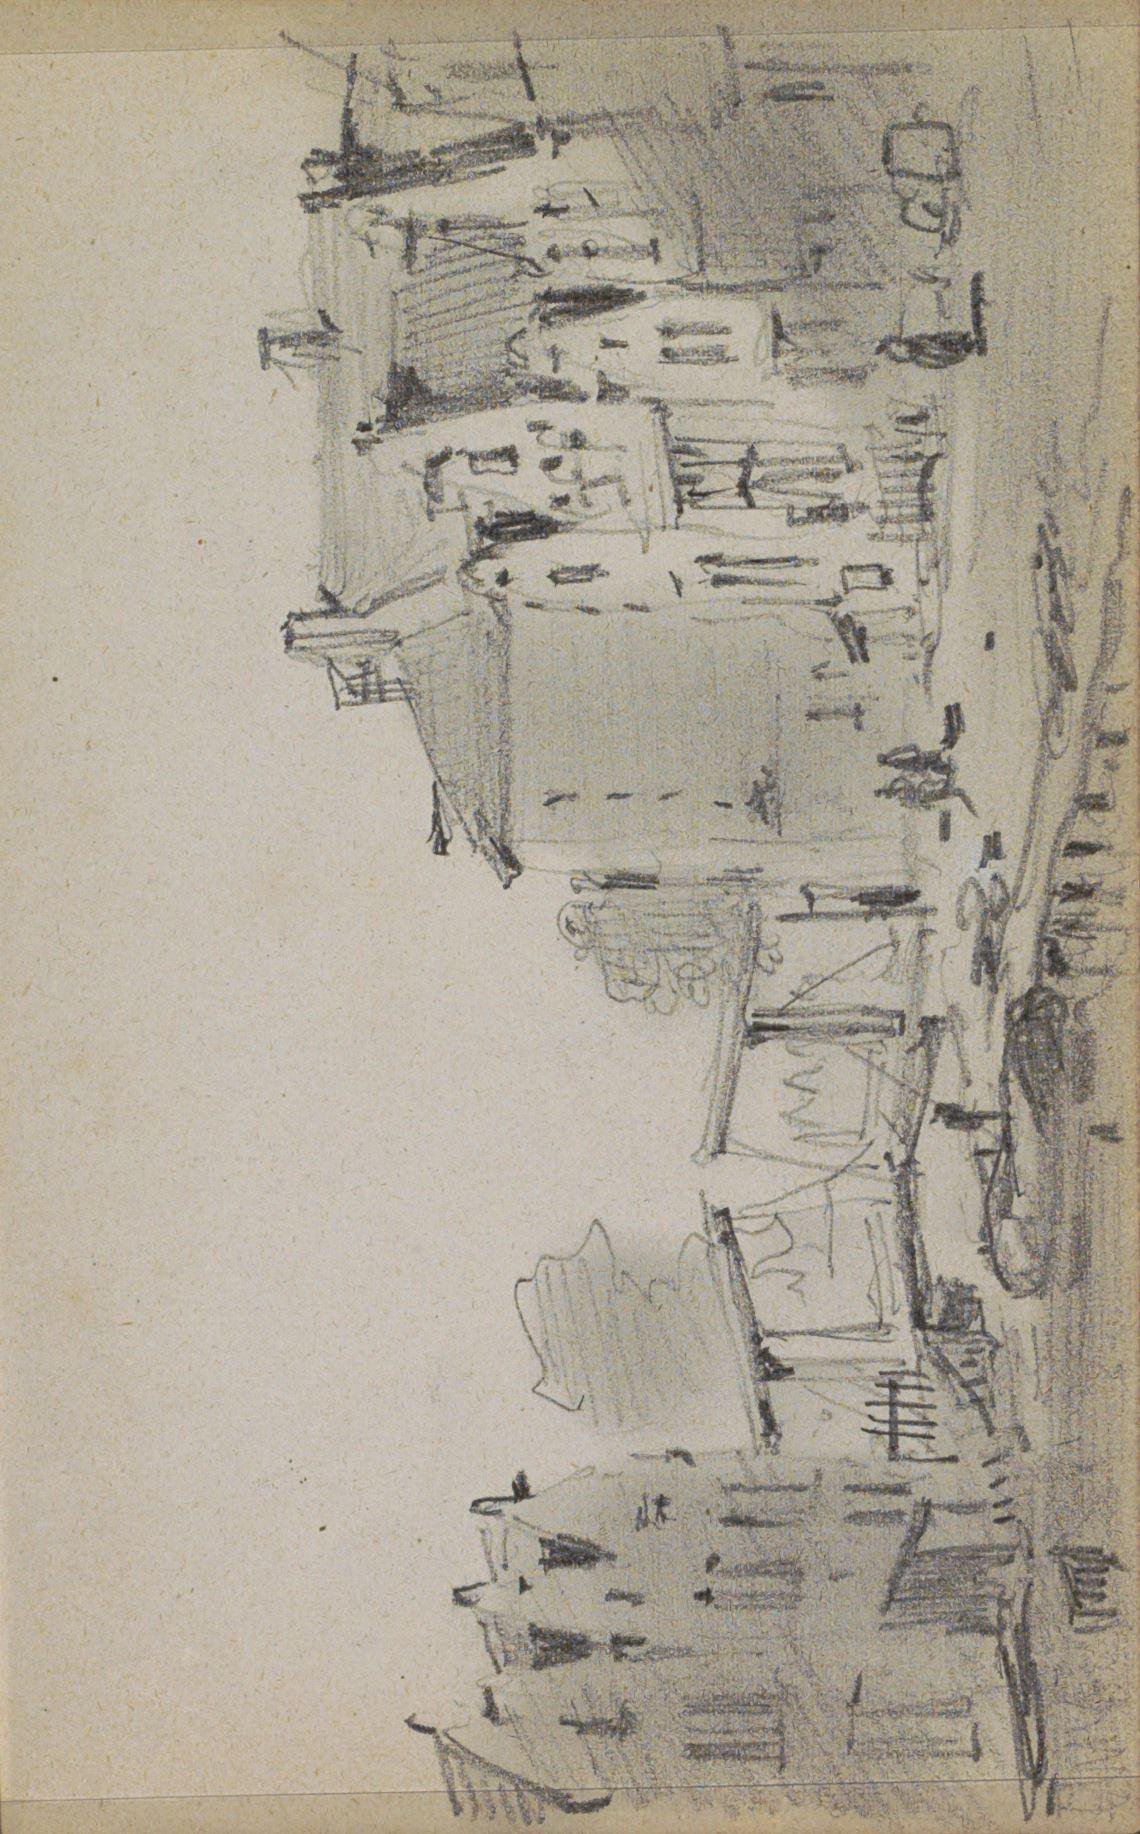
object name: sketchbook leaf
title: Stadsgezicht met een gracht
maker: adrianus eversen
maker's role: draughtsman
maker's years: 1818-1897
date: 1828-1897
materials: paper, pencil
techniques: stumping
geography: netherlands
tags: bridge in city across river, canal, etc.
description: Aan weerszijden van een gracht met een brug staan gebouwen. Vooraan een boot. Rechts figuren. Blad 29 uit een schetsboek met 58 bladen.